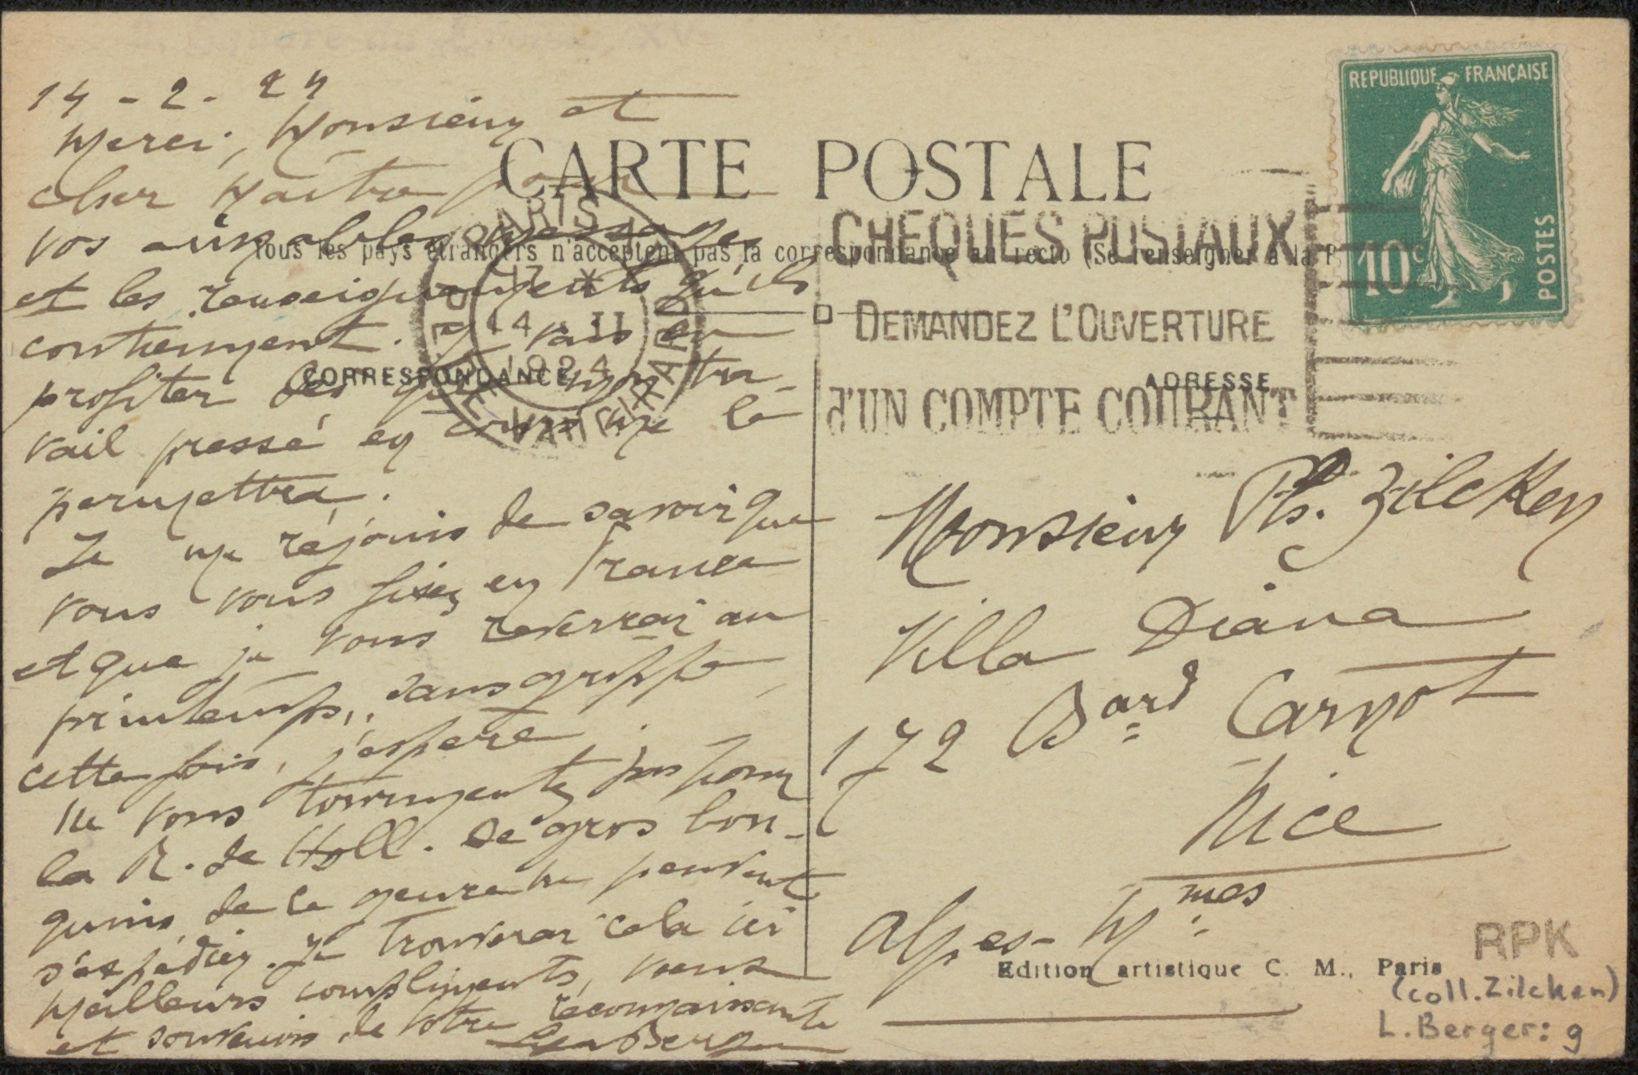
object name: ansichtkaart, prentbriefkaart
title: Prentbriefkaart aan Philip Zilcken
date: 1924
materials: cardboard, ink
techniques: photograph, pen, writing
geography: paris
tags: painter, draughtsman, philip zilcken, france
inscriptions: collector's mark: ‘RPK’